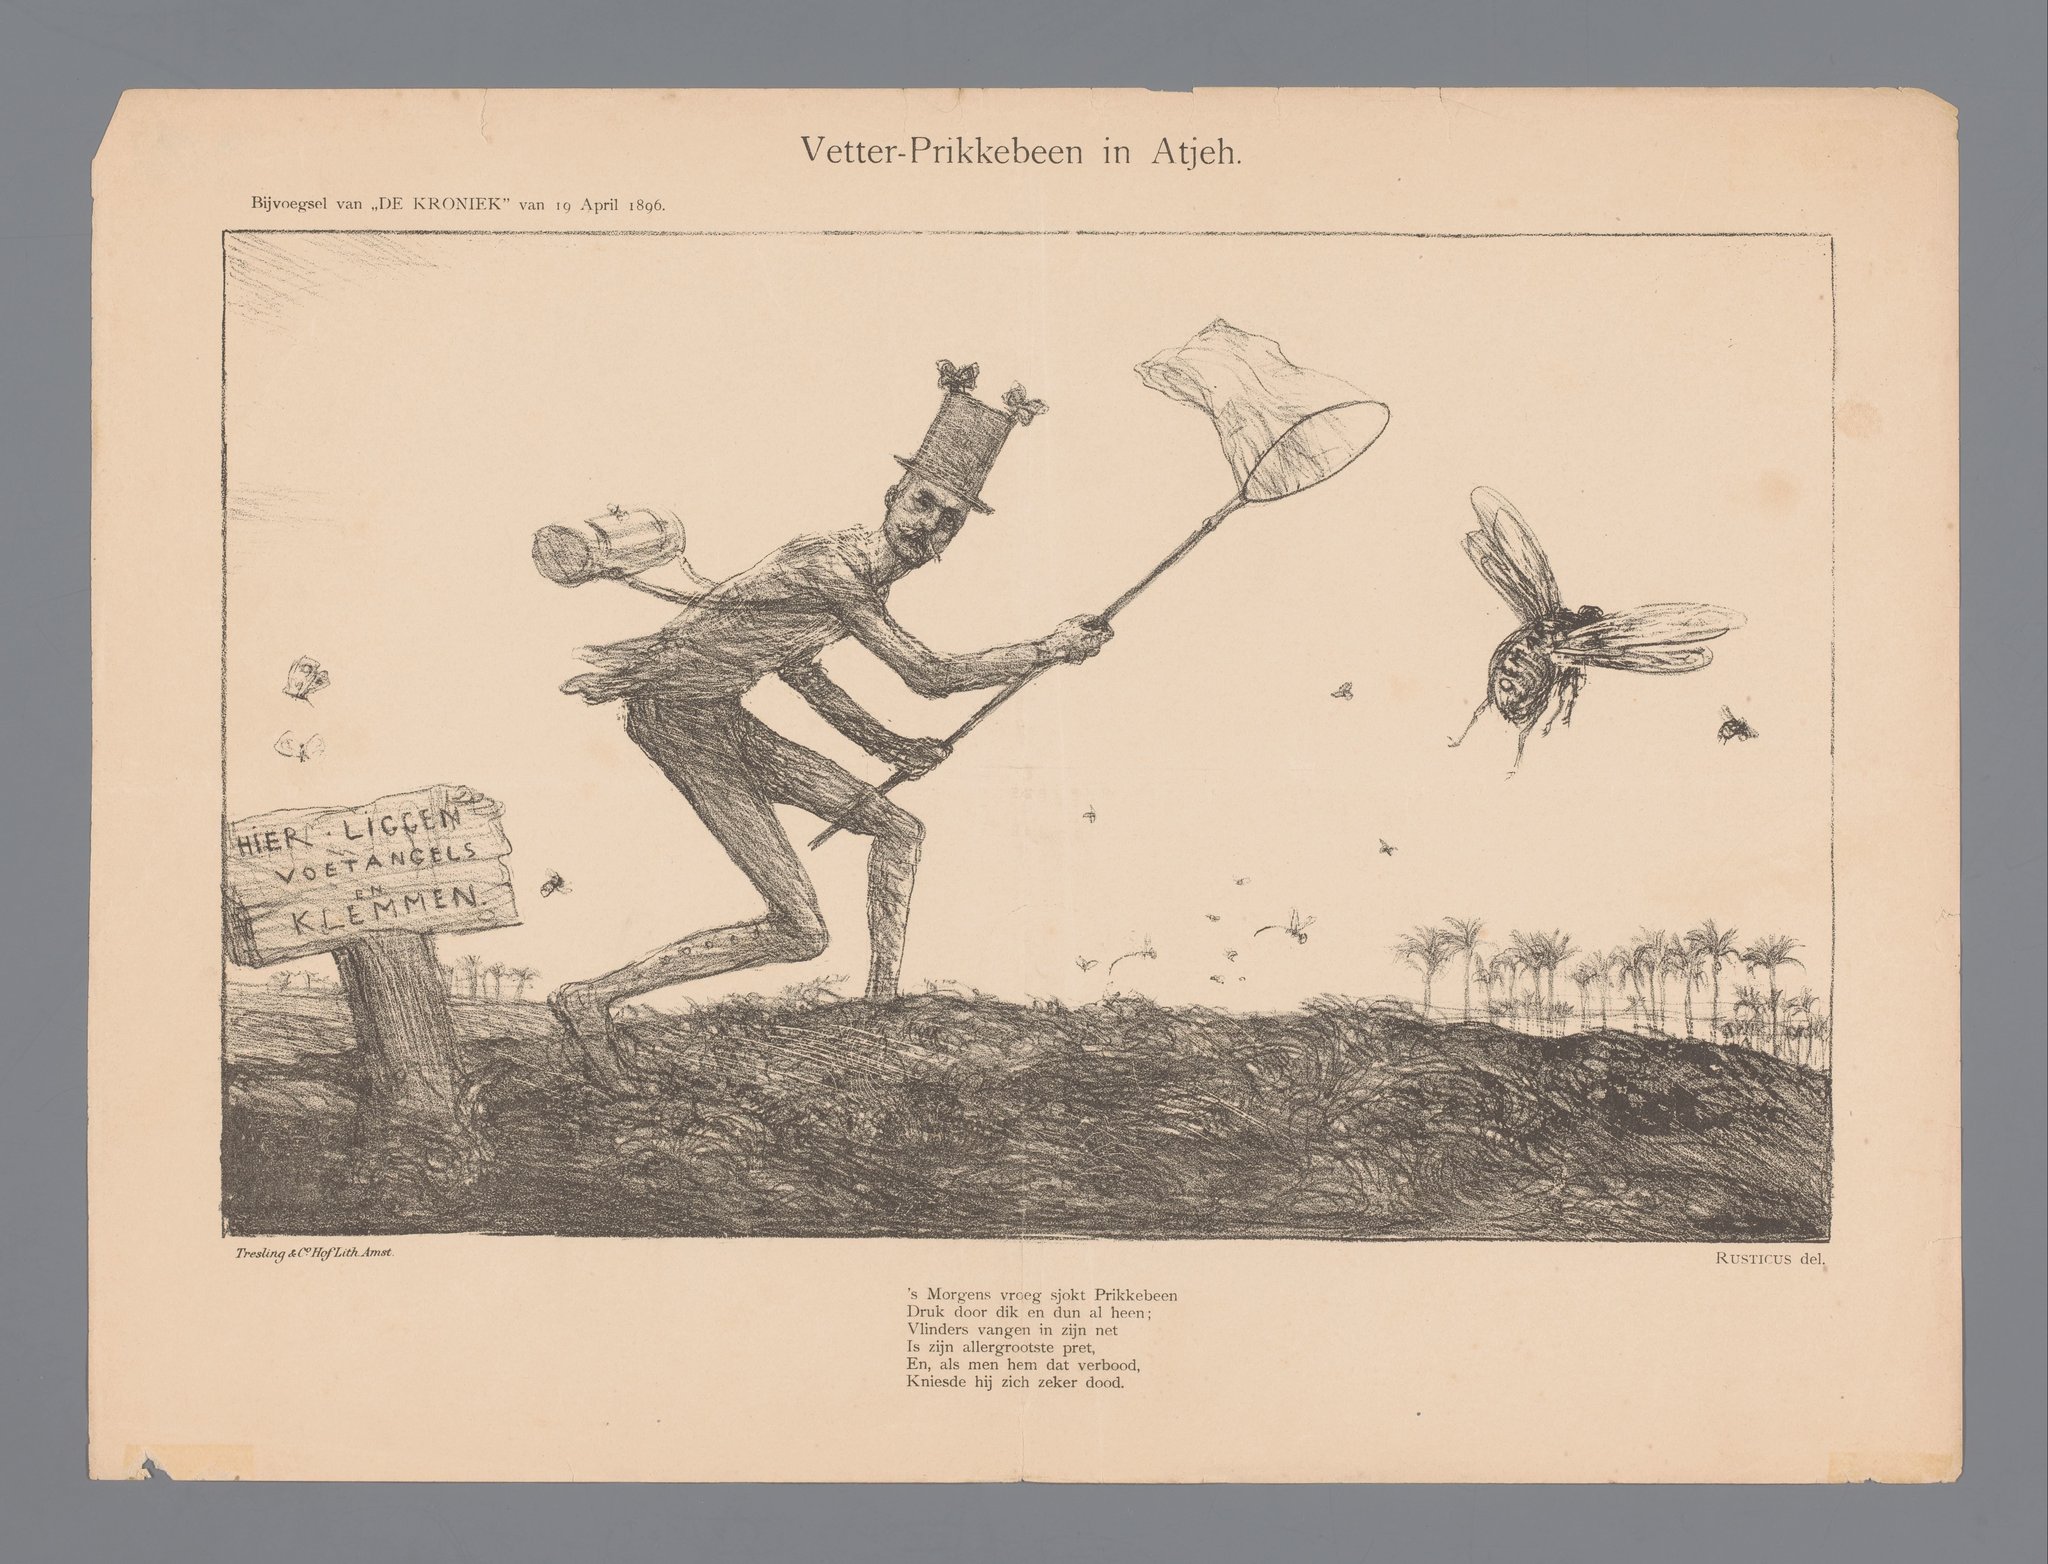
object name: print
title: Vetter-Prikkebeen in Atjeh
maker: marius bauer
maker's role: draughtsman, print maker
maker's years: 1867-1932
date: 1896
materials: paper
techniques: lithograph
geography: amsterdam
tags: the hague, historical persons, hunting butterflies, political caricatures and satires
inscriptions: date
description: Spotprent op de strijd van generaal Vetter tegen de opstand in Atjeh in 1896, het zogenaamde Verraad van Teukoe Oemar. Generaal Vetter als de vlinderjager Prikkebeen die met een vlindernet een grote wesp met de naam van Oemar (Teukoe Oemar, leider van de opstand) probeert te vangen.